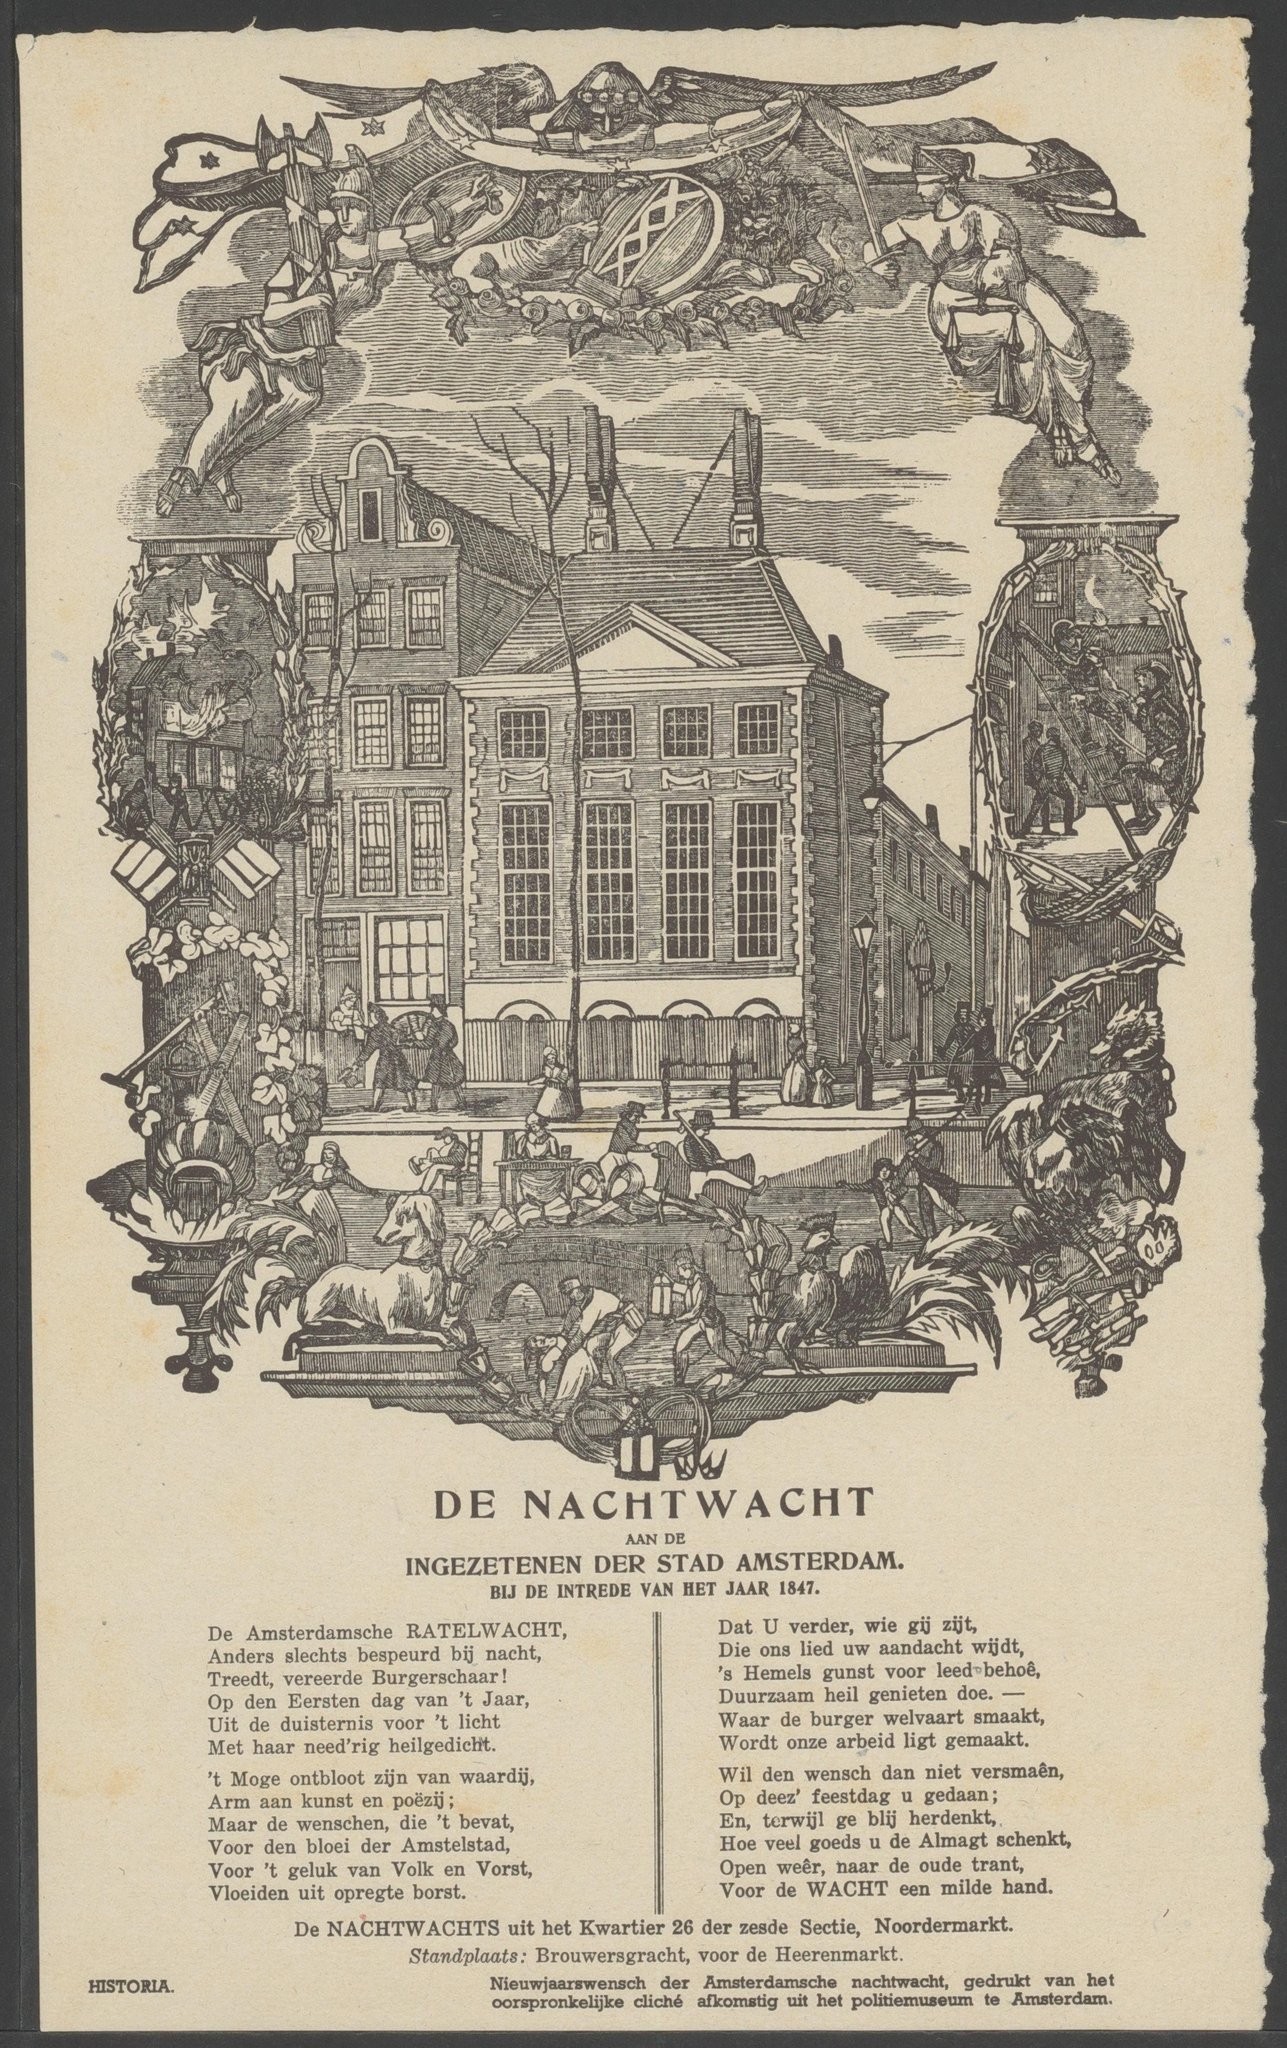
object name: print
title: Nieuwjaarswens van de Amsterdamse nachtwacht voor het jaar 1847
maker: Anonymous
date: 1940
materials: paper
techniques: letterpress printing, engraving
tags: night patrol, street, amsterdam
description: Nieuwjaarswens van de Amsterdamse nachtwacht (ratelwacht) voor het jaar 1847. Centraal het Politiebureau op de Oudezijds Achterburgwal 183-185 met de Spinhuissteeg. Met schaatsers op het ijs. Binnen een kader met kleine voorstellingen van het werk van de nachtwacht. Met een vers in twee kolommen. Namens de nachtwacht in kwartier No. 26 van de 6de Sectie, Noordermarkt. Onderwerpsrubrieken binnen de Atlas Zeden en Gewoonten: Zeden en gewoonten in engeren zin, Volksleven, Volksbladen, Nieuwjaars- en Kerstwenschen, Amsterdam.